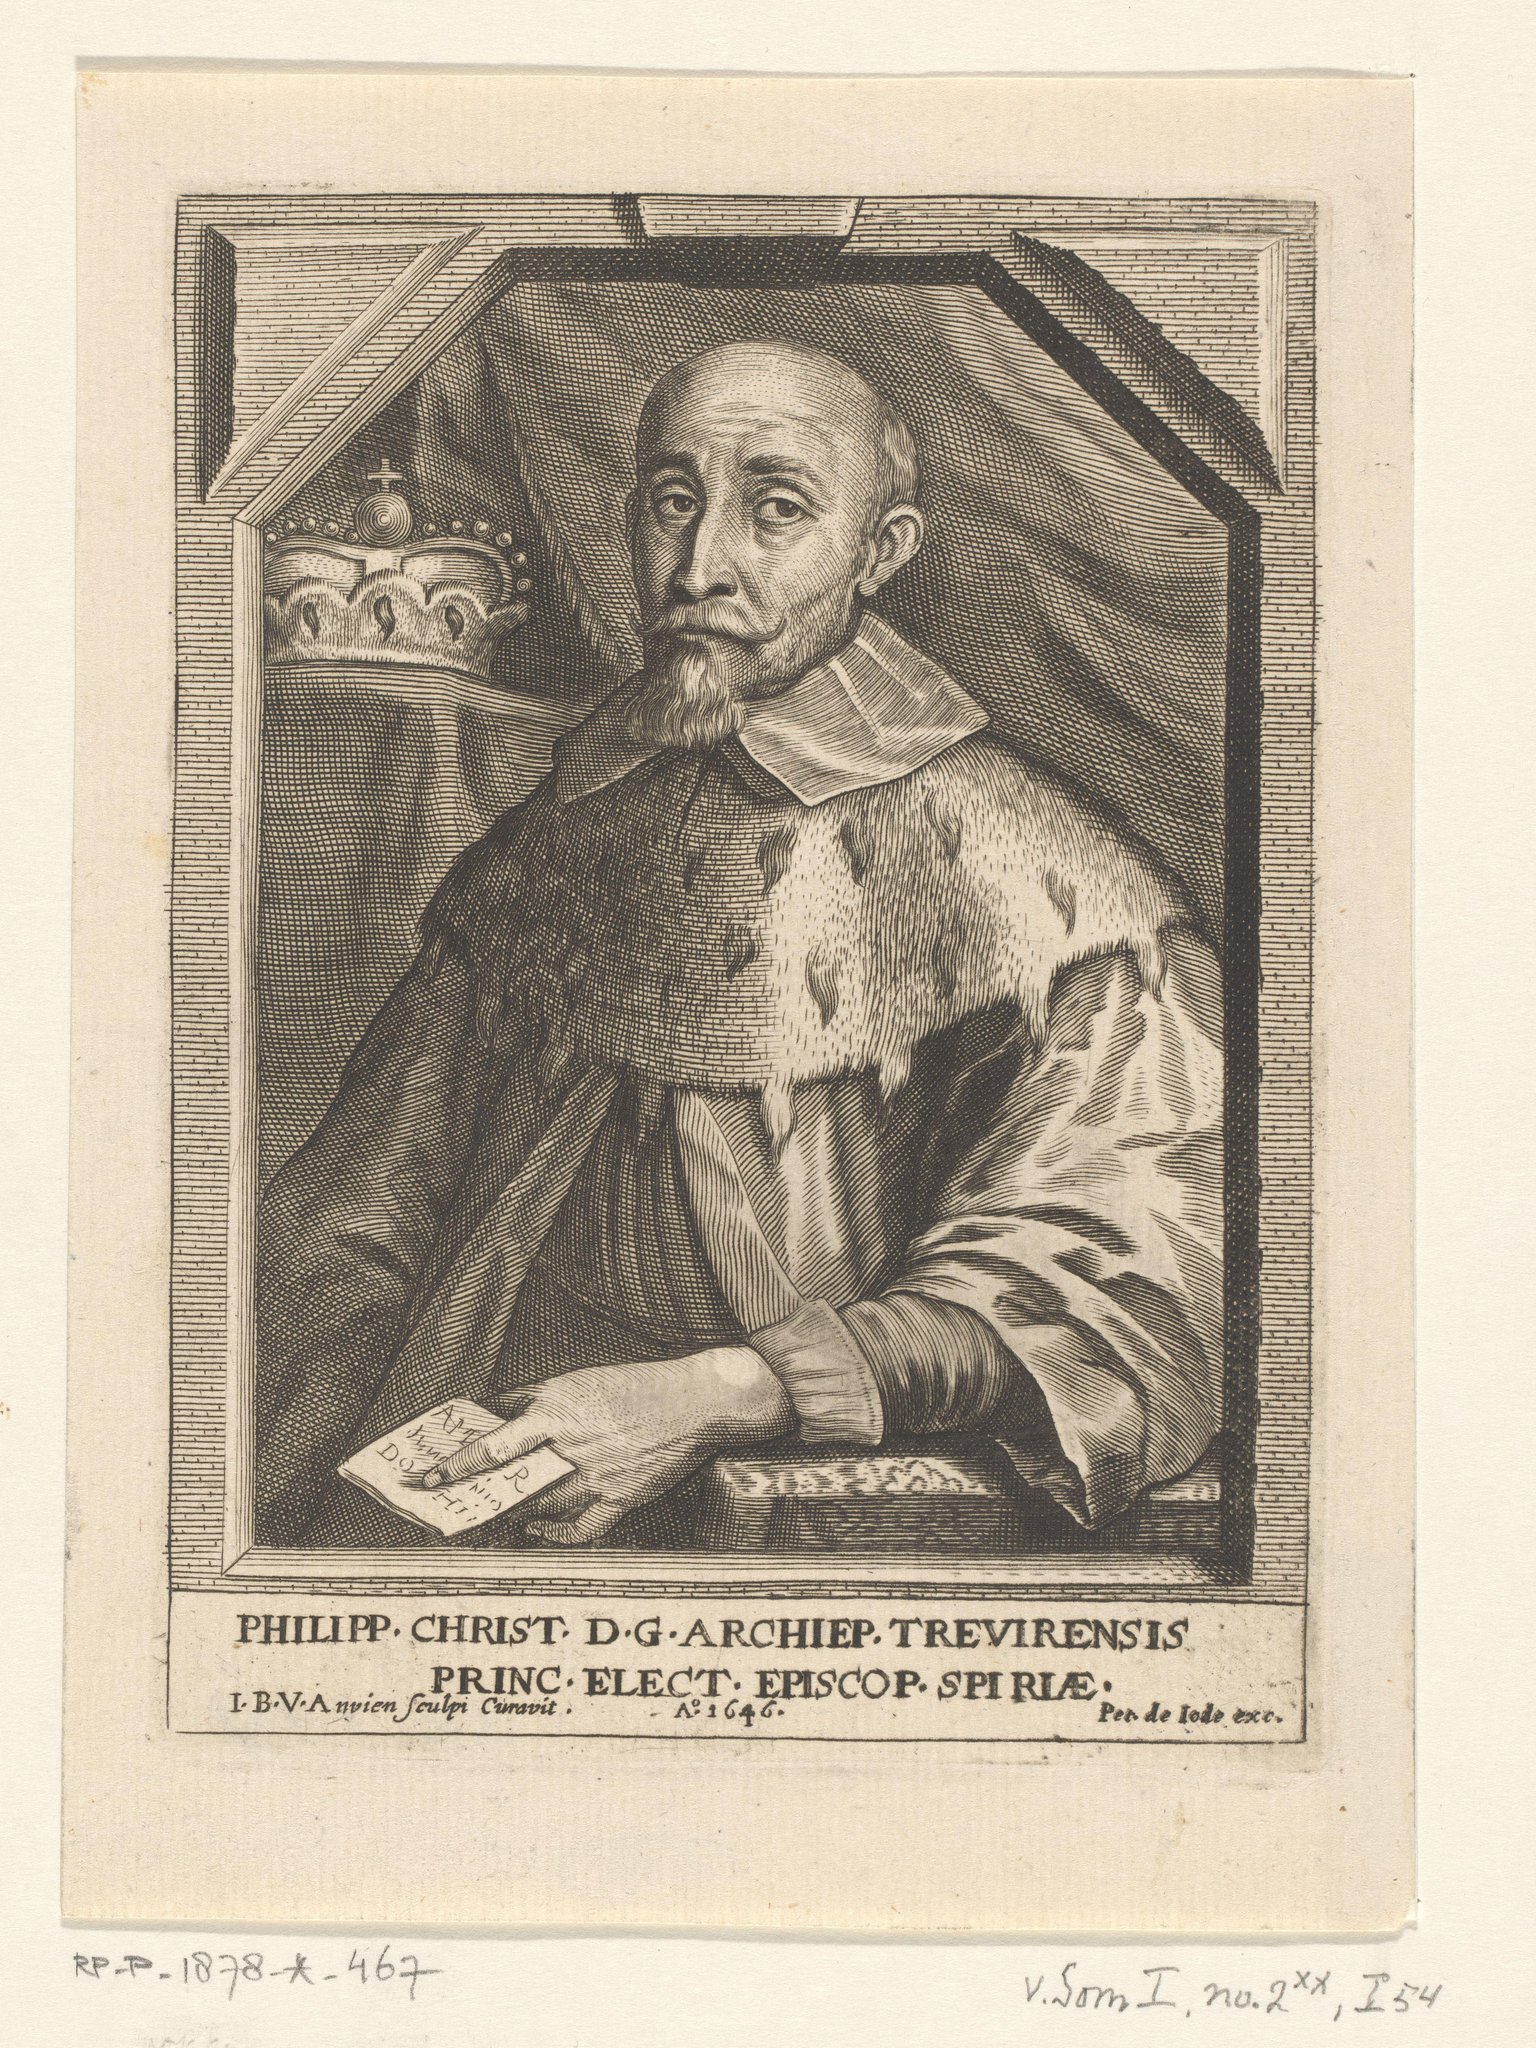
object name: print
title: Portret van Philip Christoph von Sötern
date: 1646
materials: paper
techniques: engraving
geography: antwerp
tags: crown (symbol of sovereignty), archbishop, bishop, etc. (roman catholic), historical persons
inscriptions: collector's mark: Lugt 2228